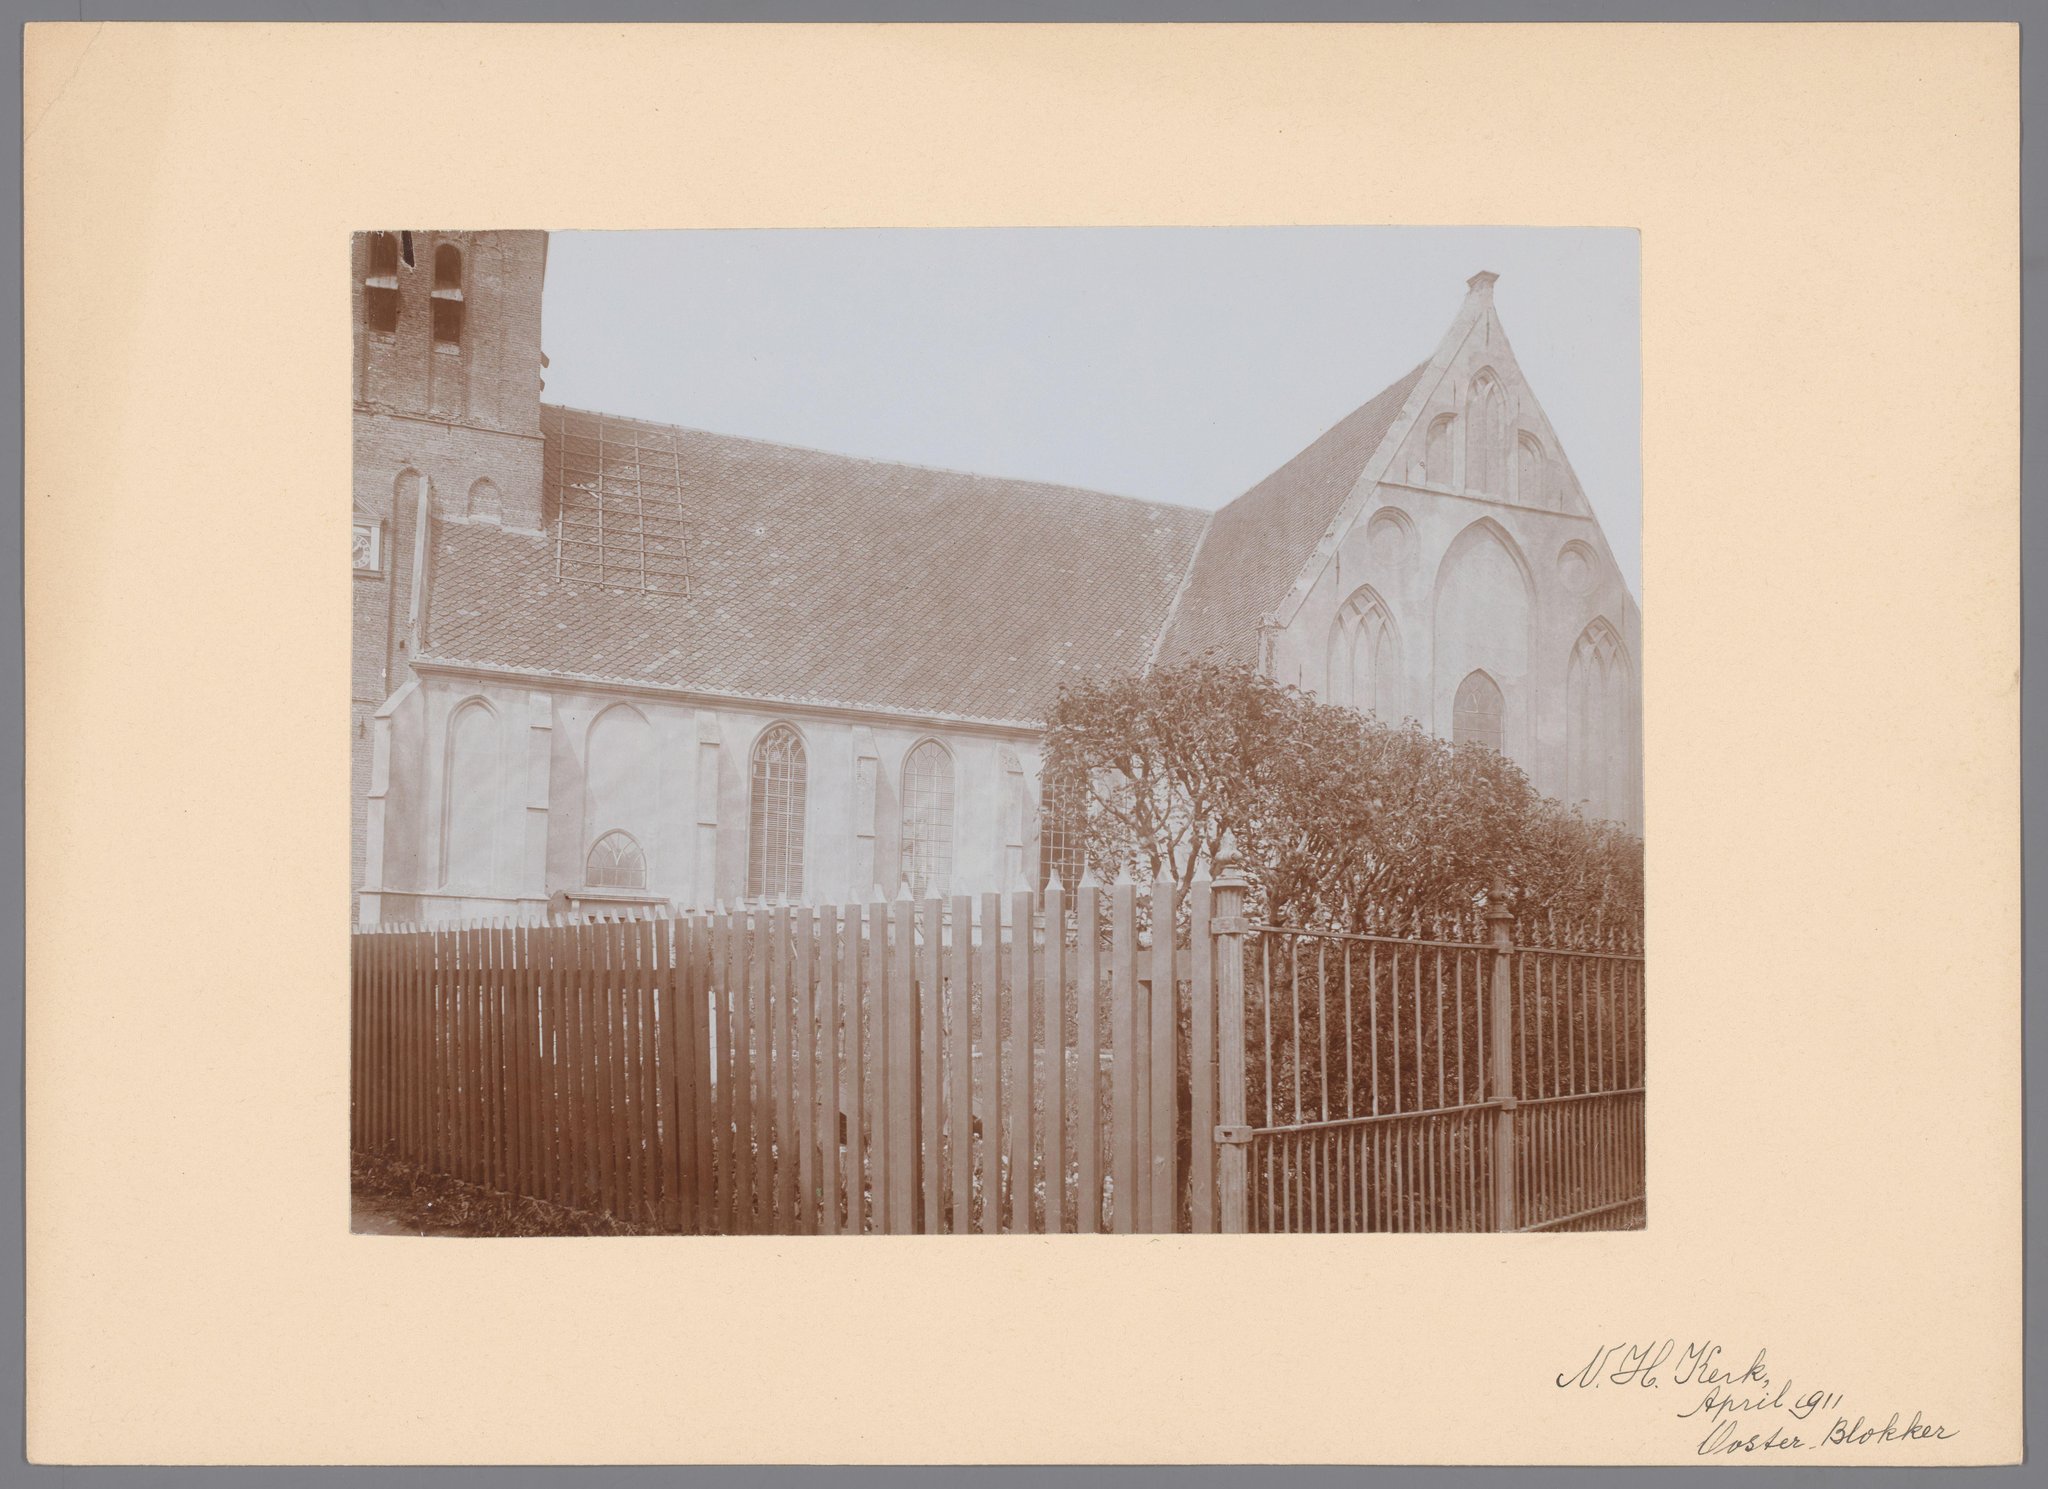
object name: photograph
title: Hervormde Kerk te Oosterblokker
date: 1911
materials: cardboard, photographic support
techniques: collodion silver print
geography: oosterblokker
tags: church (exterior)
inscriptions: annotation: ‘N.H. Kerk, April 1911/ Ooster-Blokker’